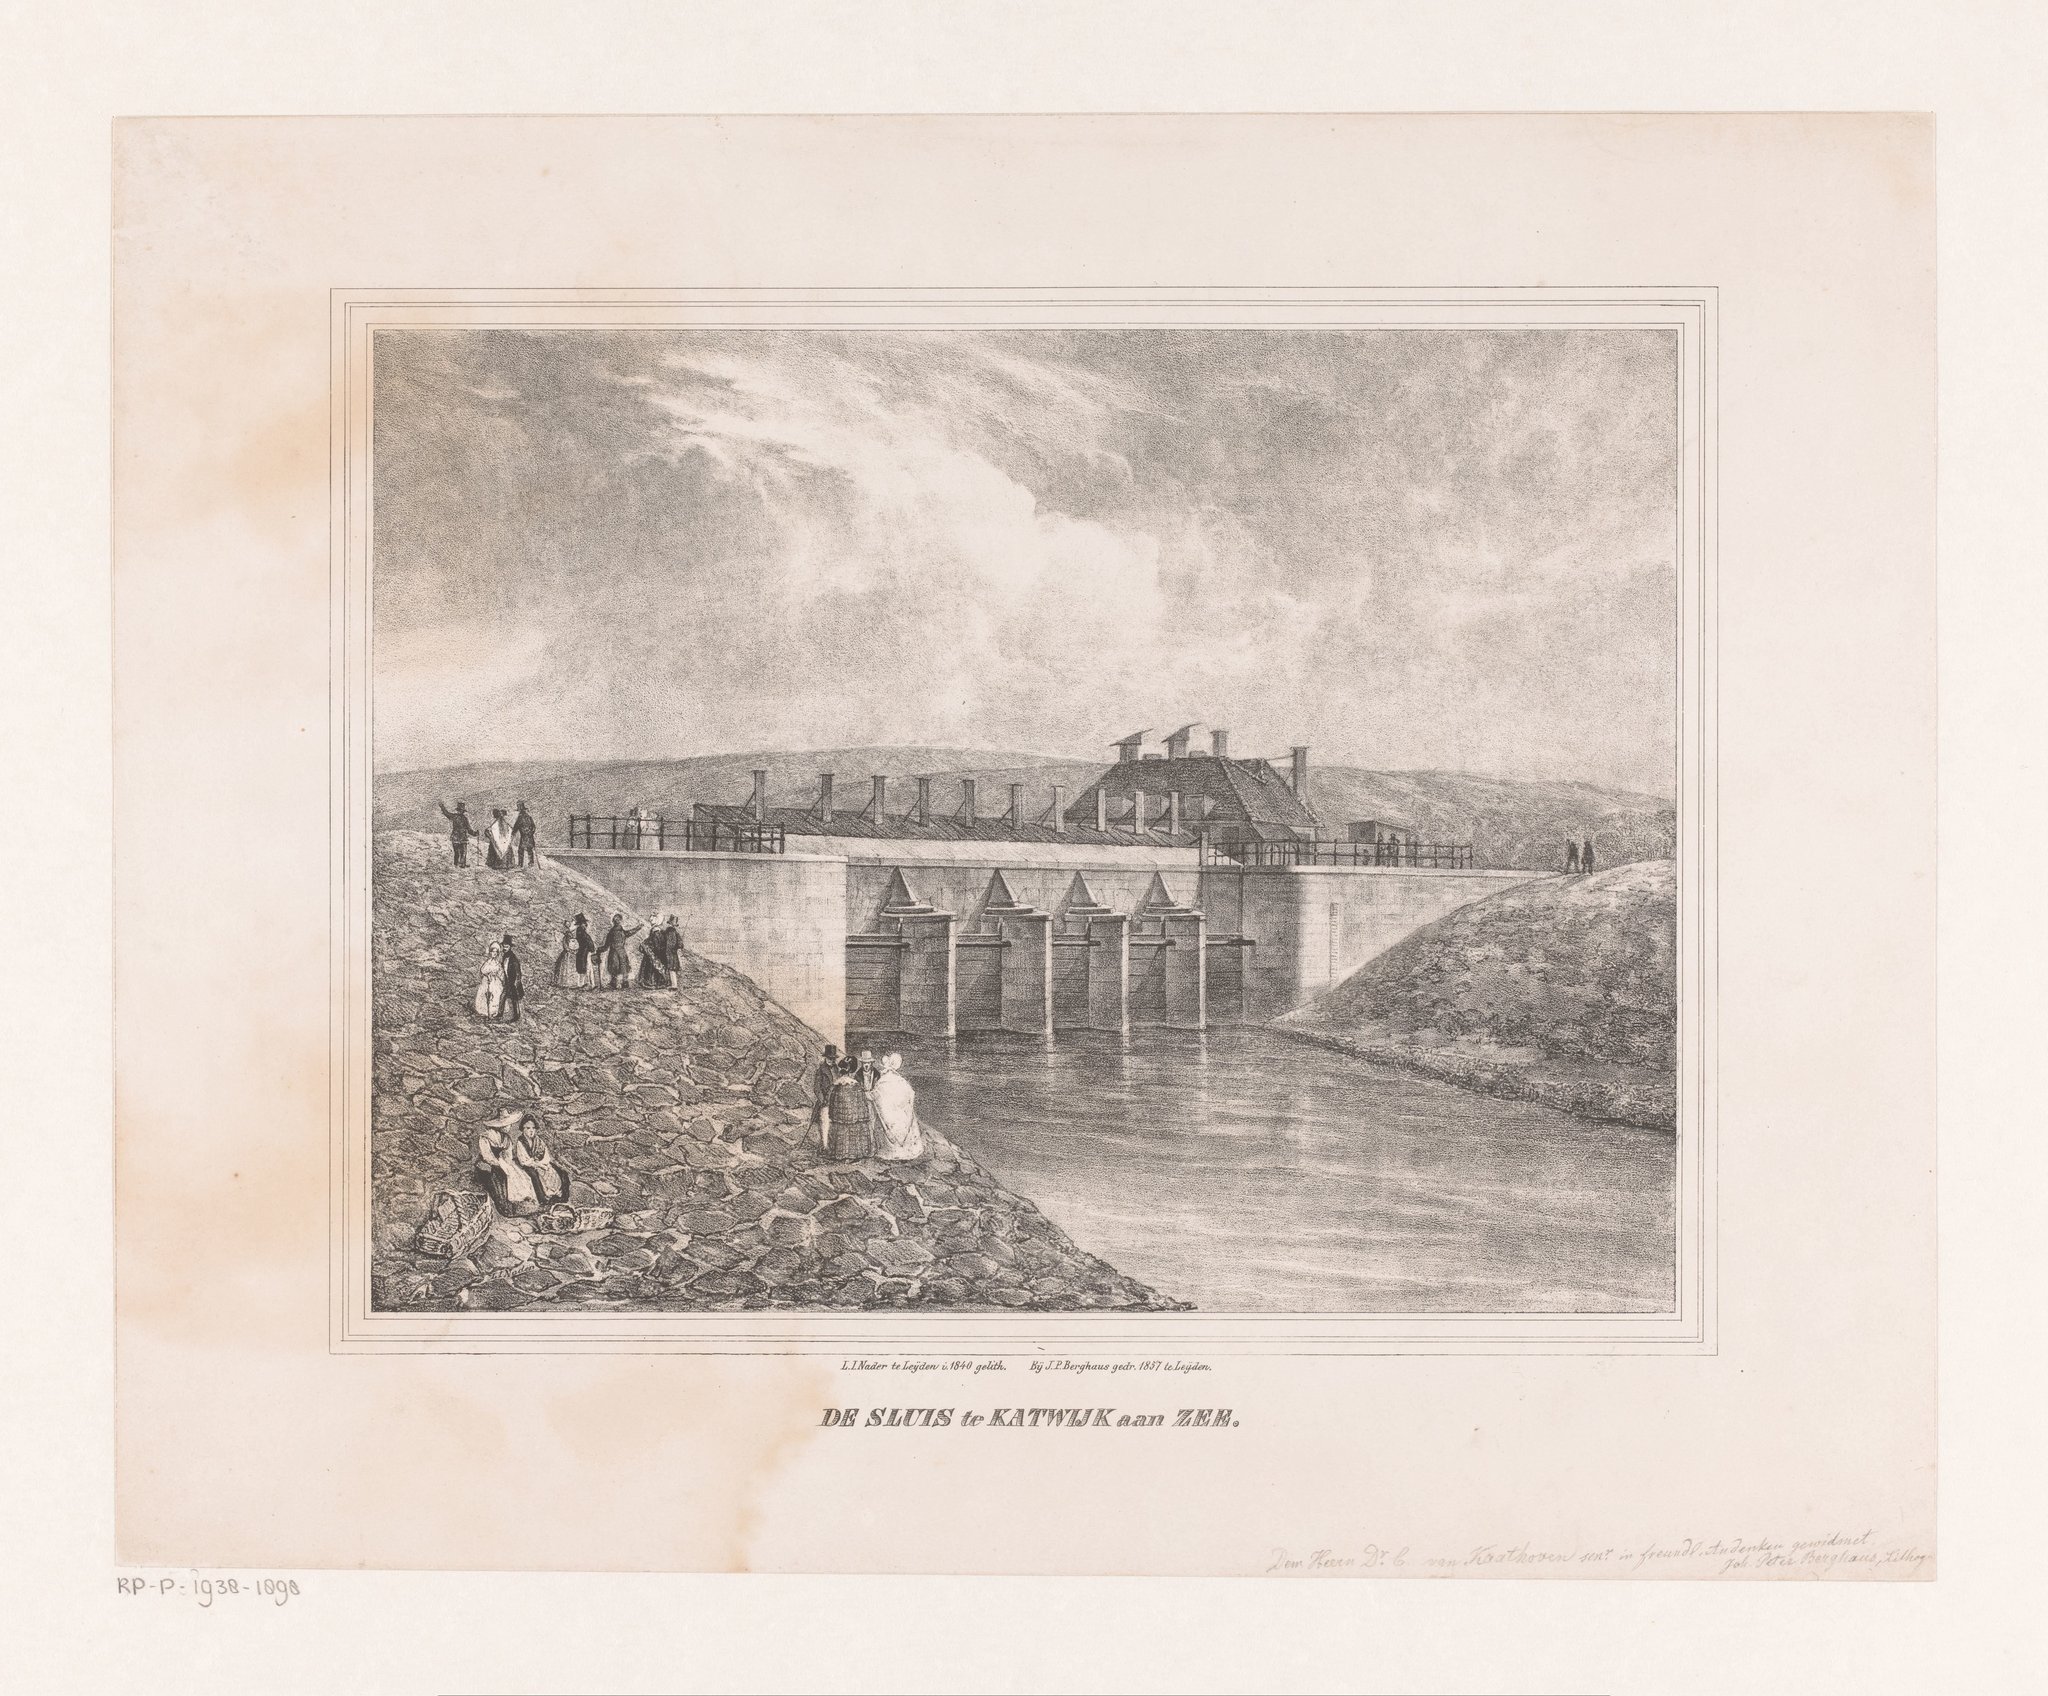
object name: print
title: De Sluis te Katwijk aan Zee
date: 1821-1840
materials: paper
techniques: lithograph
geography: leiden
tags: sluice, weir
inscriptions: collector's mark: Lugt 2760, dedication: ‘Dem Heern Dr. C. van Kaathoven sen.r in freundl. Andenken gewidmet / Joh. Peter Berghaus lithog.’, collector's mark: Lugt 2228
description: Mensen op de oever bij de sluis te Katwijk aan Zee.